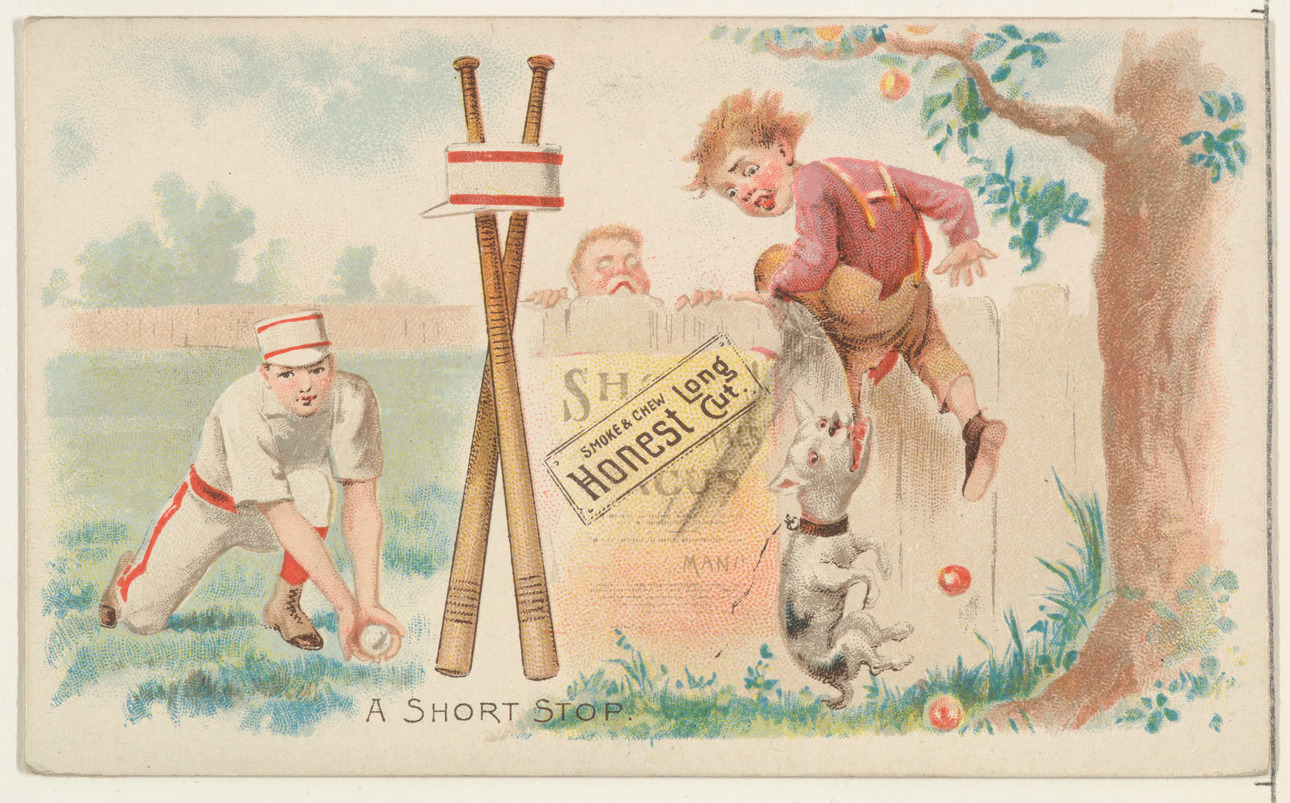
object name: print, baseball card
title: A Short Stop, from the Talk of the Diamond set (N135) issued by Duke Sons & Co., a branch of the American Tobacco Company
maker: w. duke, sons & co.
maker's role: publisher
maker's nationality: american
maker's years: 1870-1920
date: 1888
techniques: color lithograph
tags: boys,men,baseball,dogs,athletes